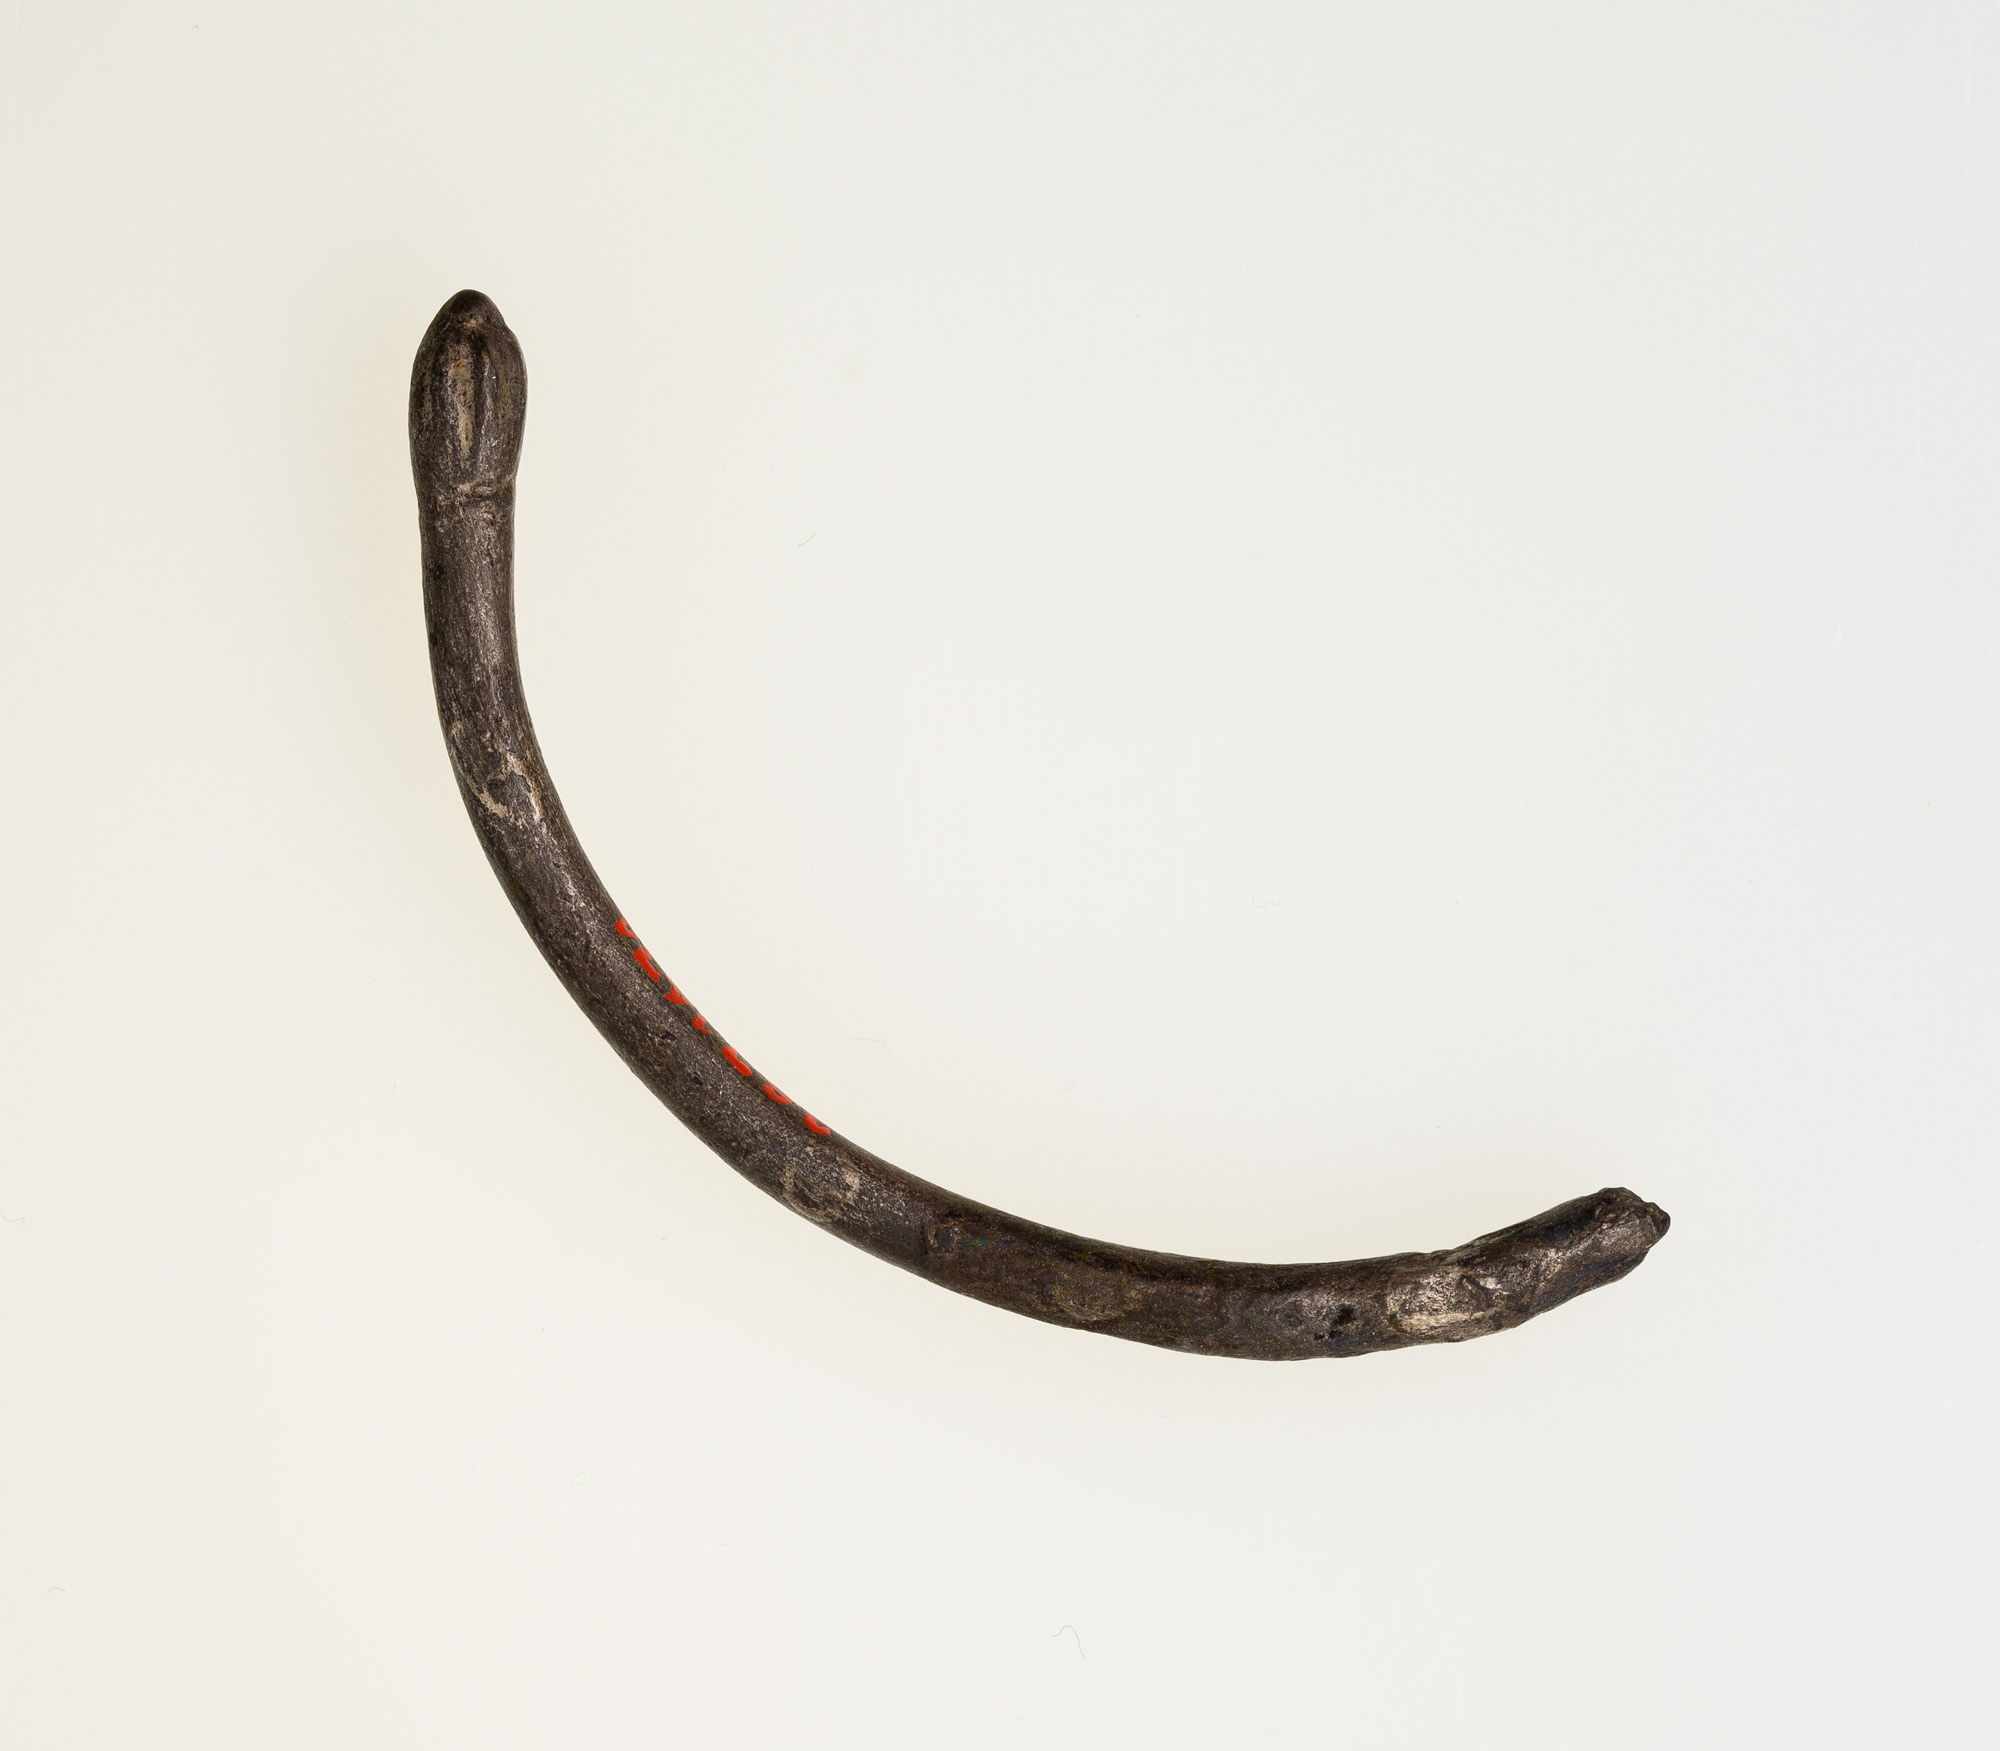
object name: bracelet, bangle, fragment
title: Part of a bangle (?)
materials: silver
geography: egypt